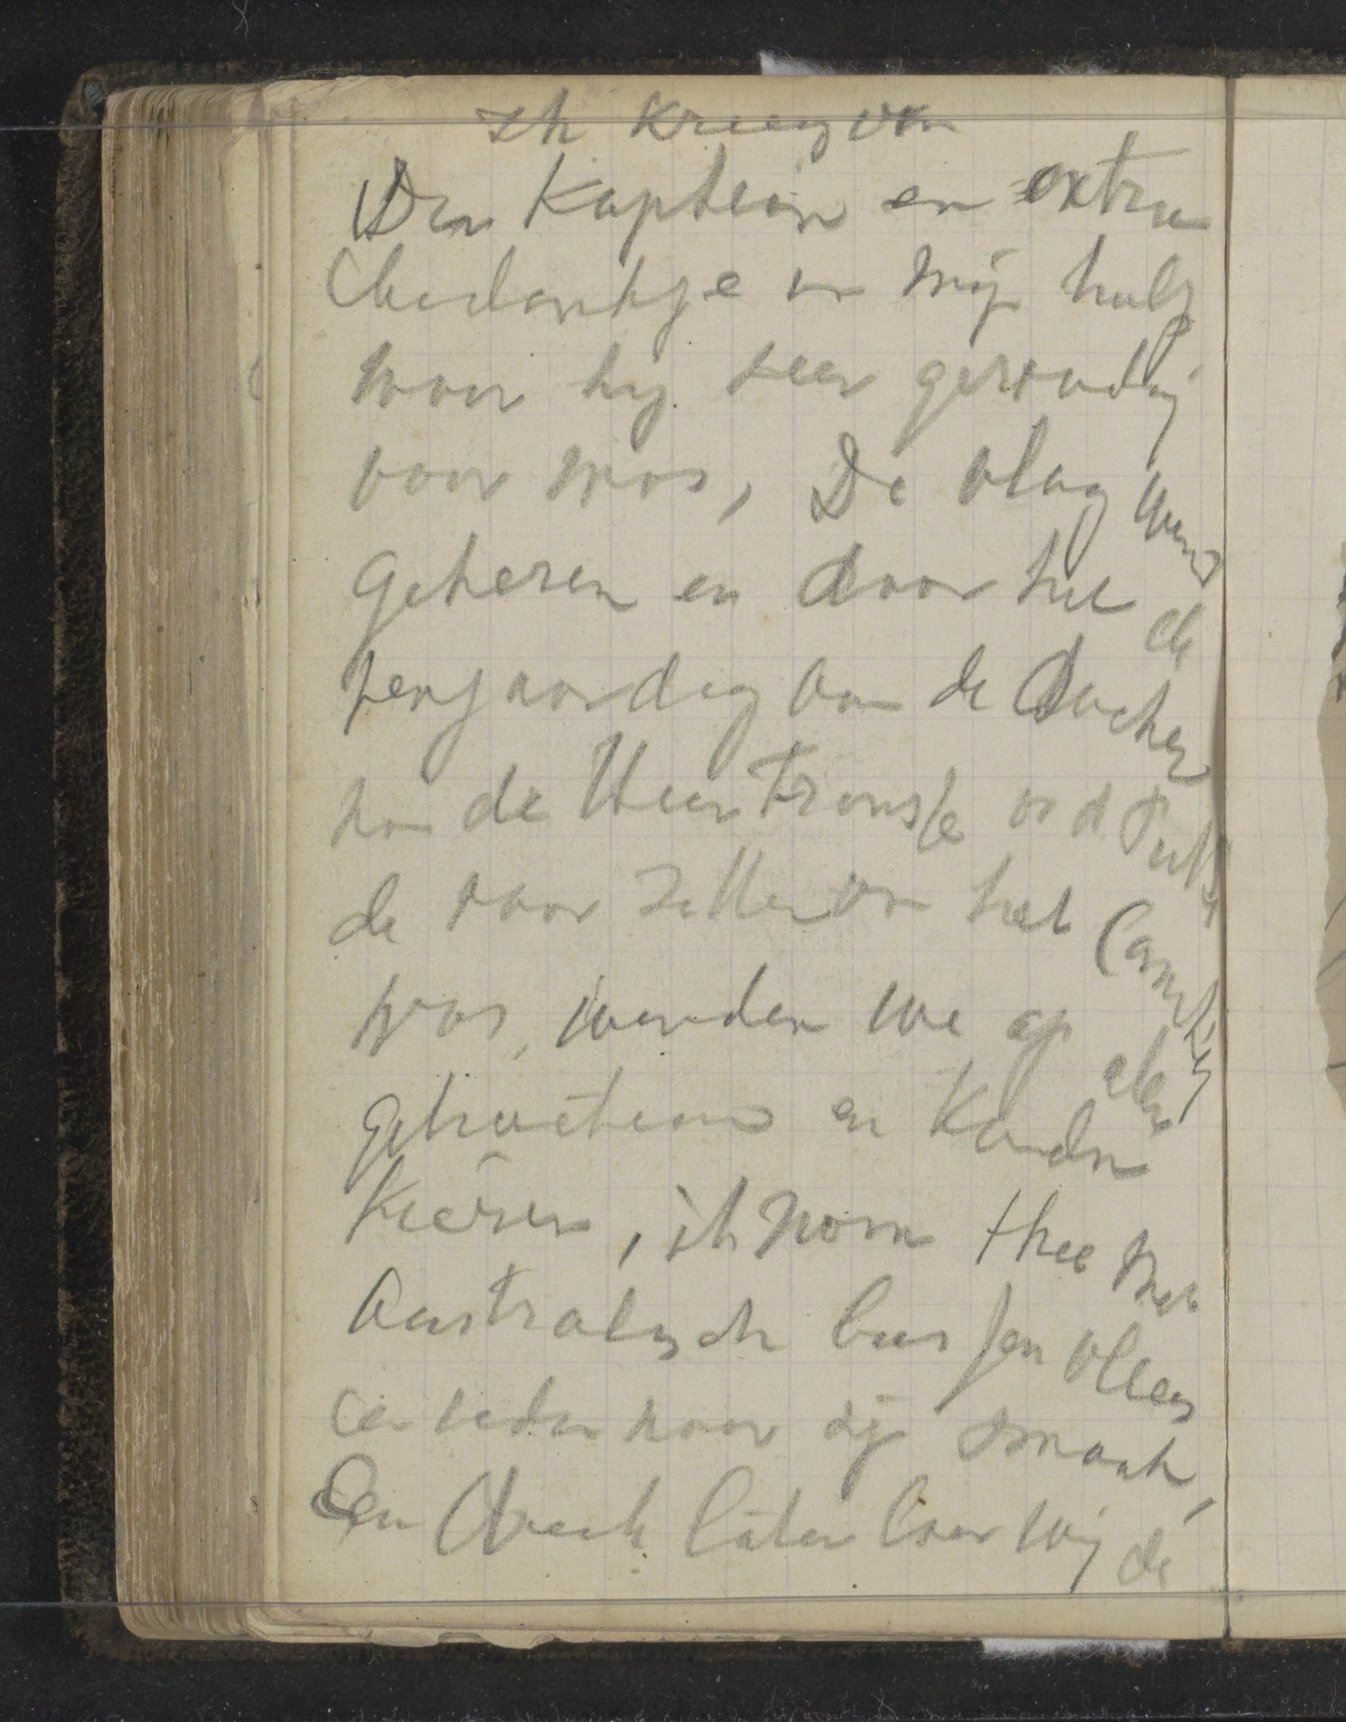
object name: sketchbook leaf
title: Reisverslag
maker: louis apol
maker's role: draughtsman, painter, print maker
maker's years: 1850-1936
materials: pencil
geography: novaya zemlya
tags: nova zembla expedities 1880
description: Blad 98 verso uit een schetsboek met 110 bladen betekend tijdens de expeditie naar Nova Zembla in 1880.